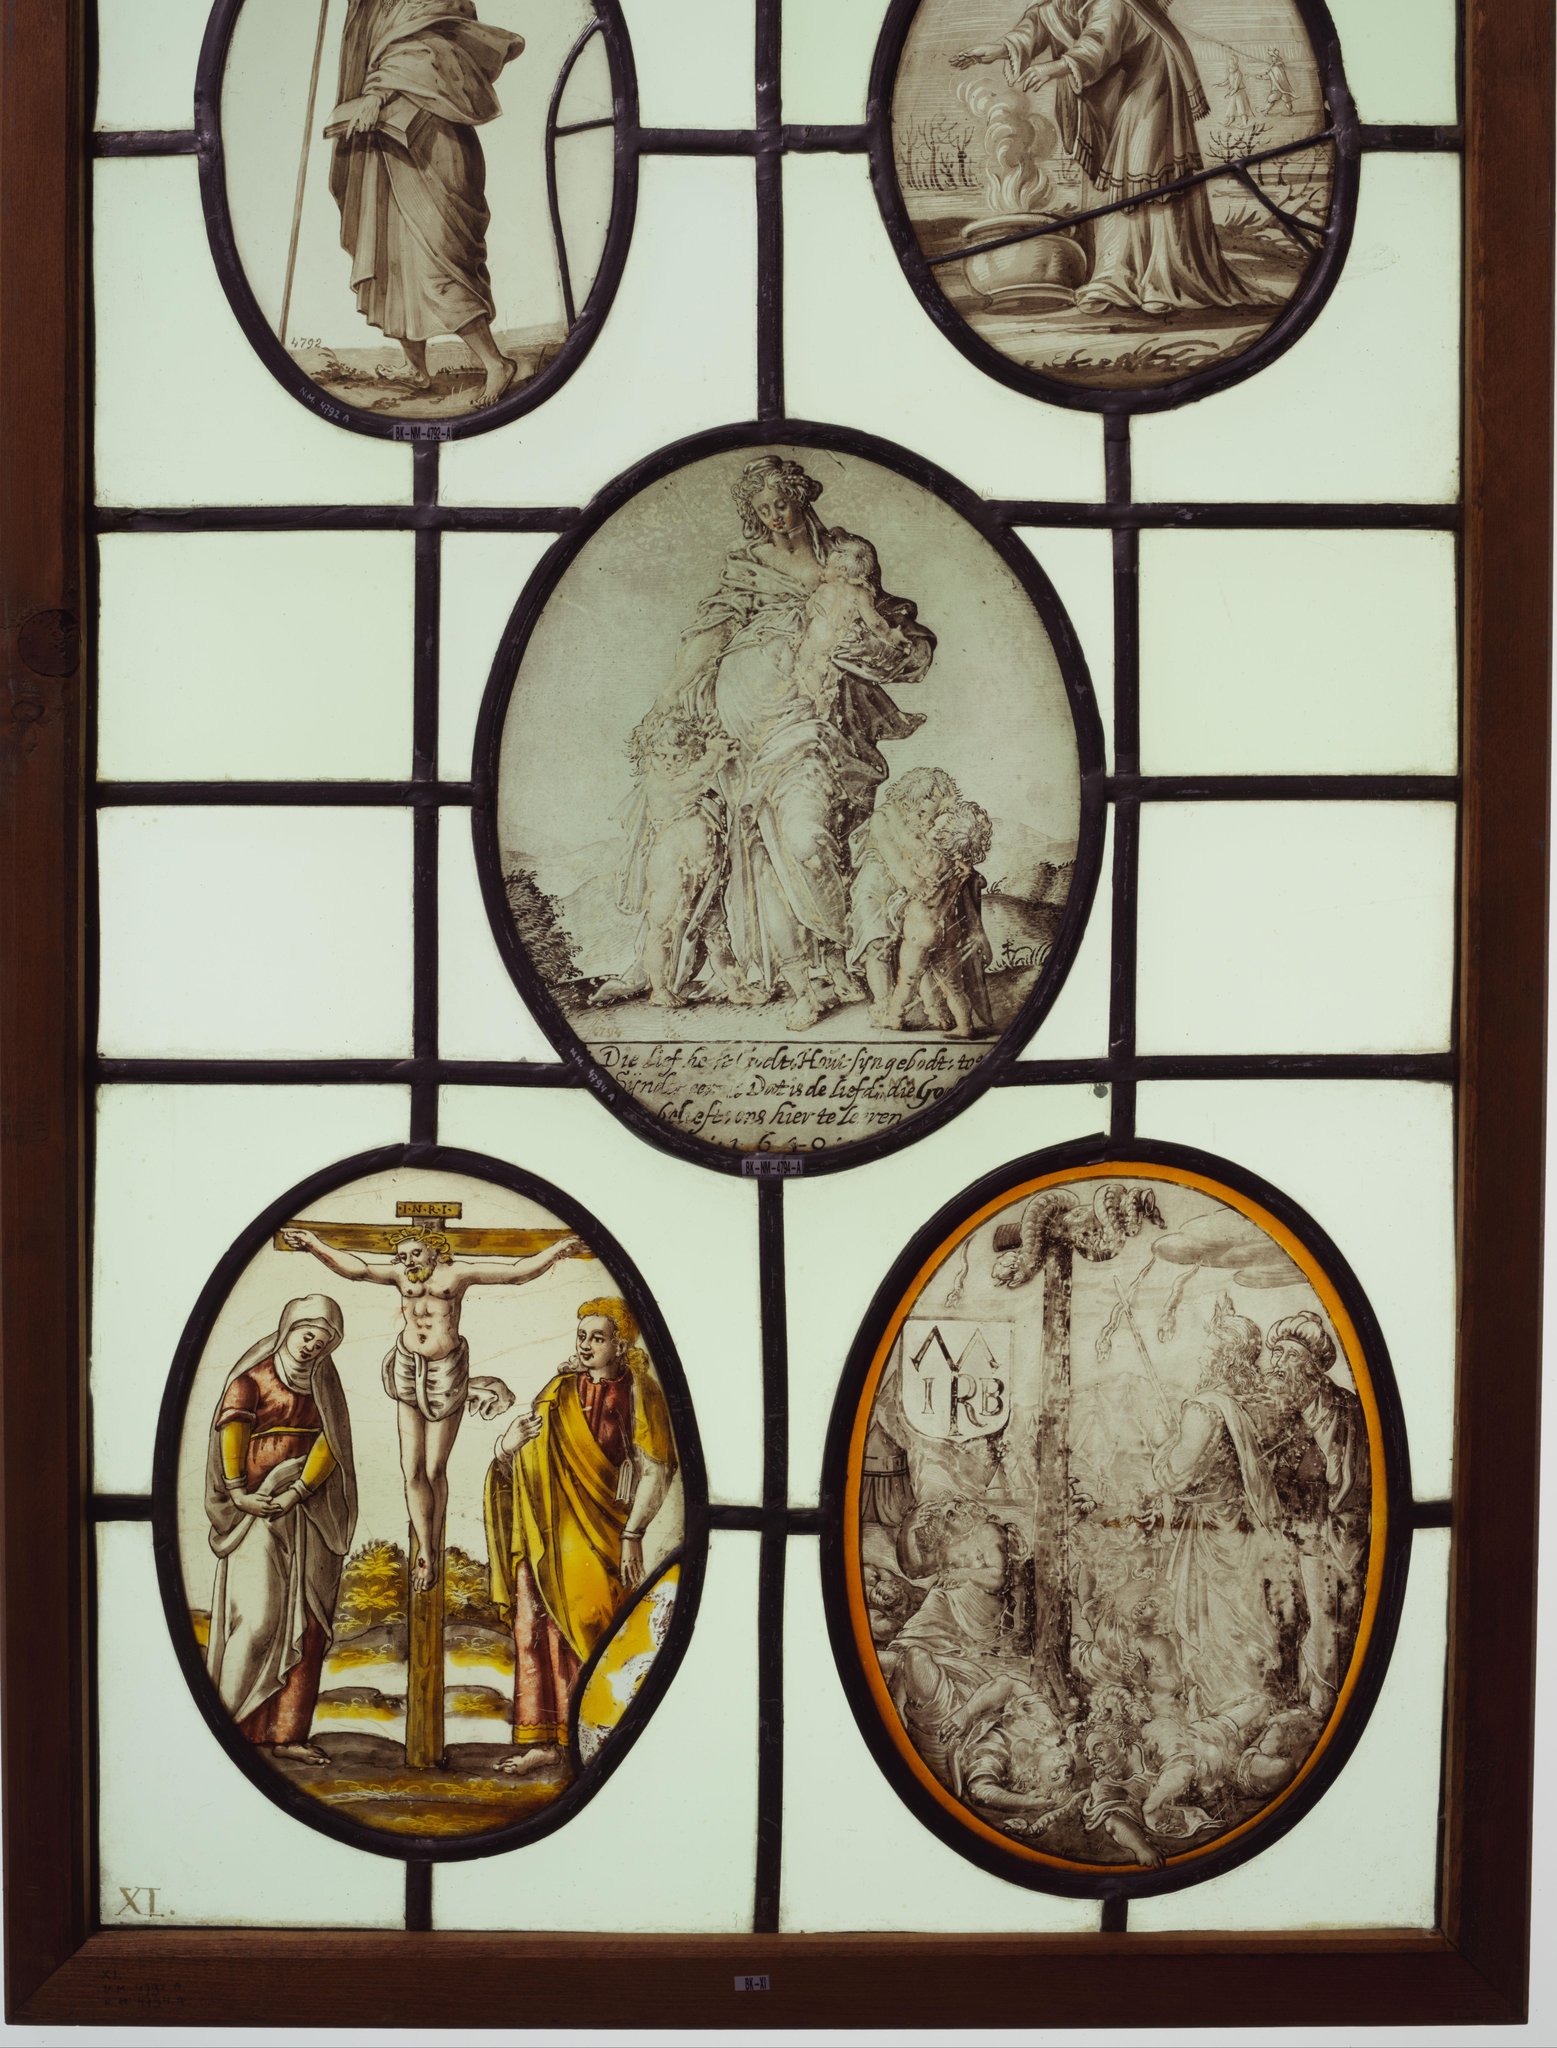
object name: light window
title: Ruit met evangelist met speer en bijbel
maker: Anonymous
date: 1700-1800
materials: glass, lead, pigment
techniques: leading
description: Ruit met evangelist met speer en bijbel.